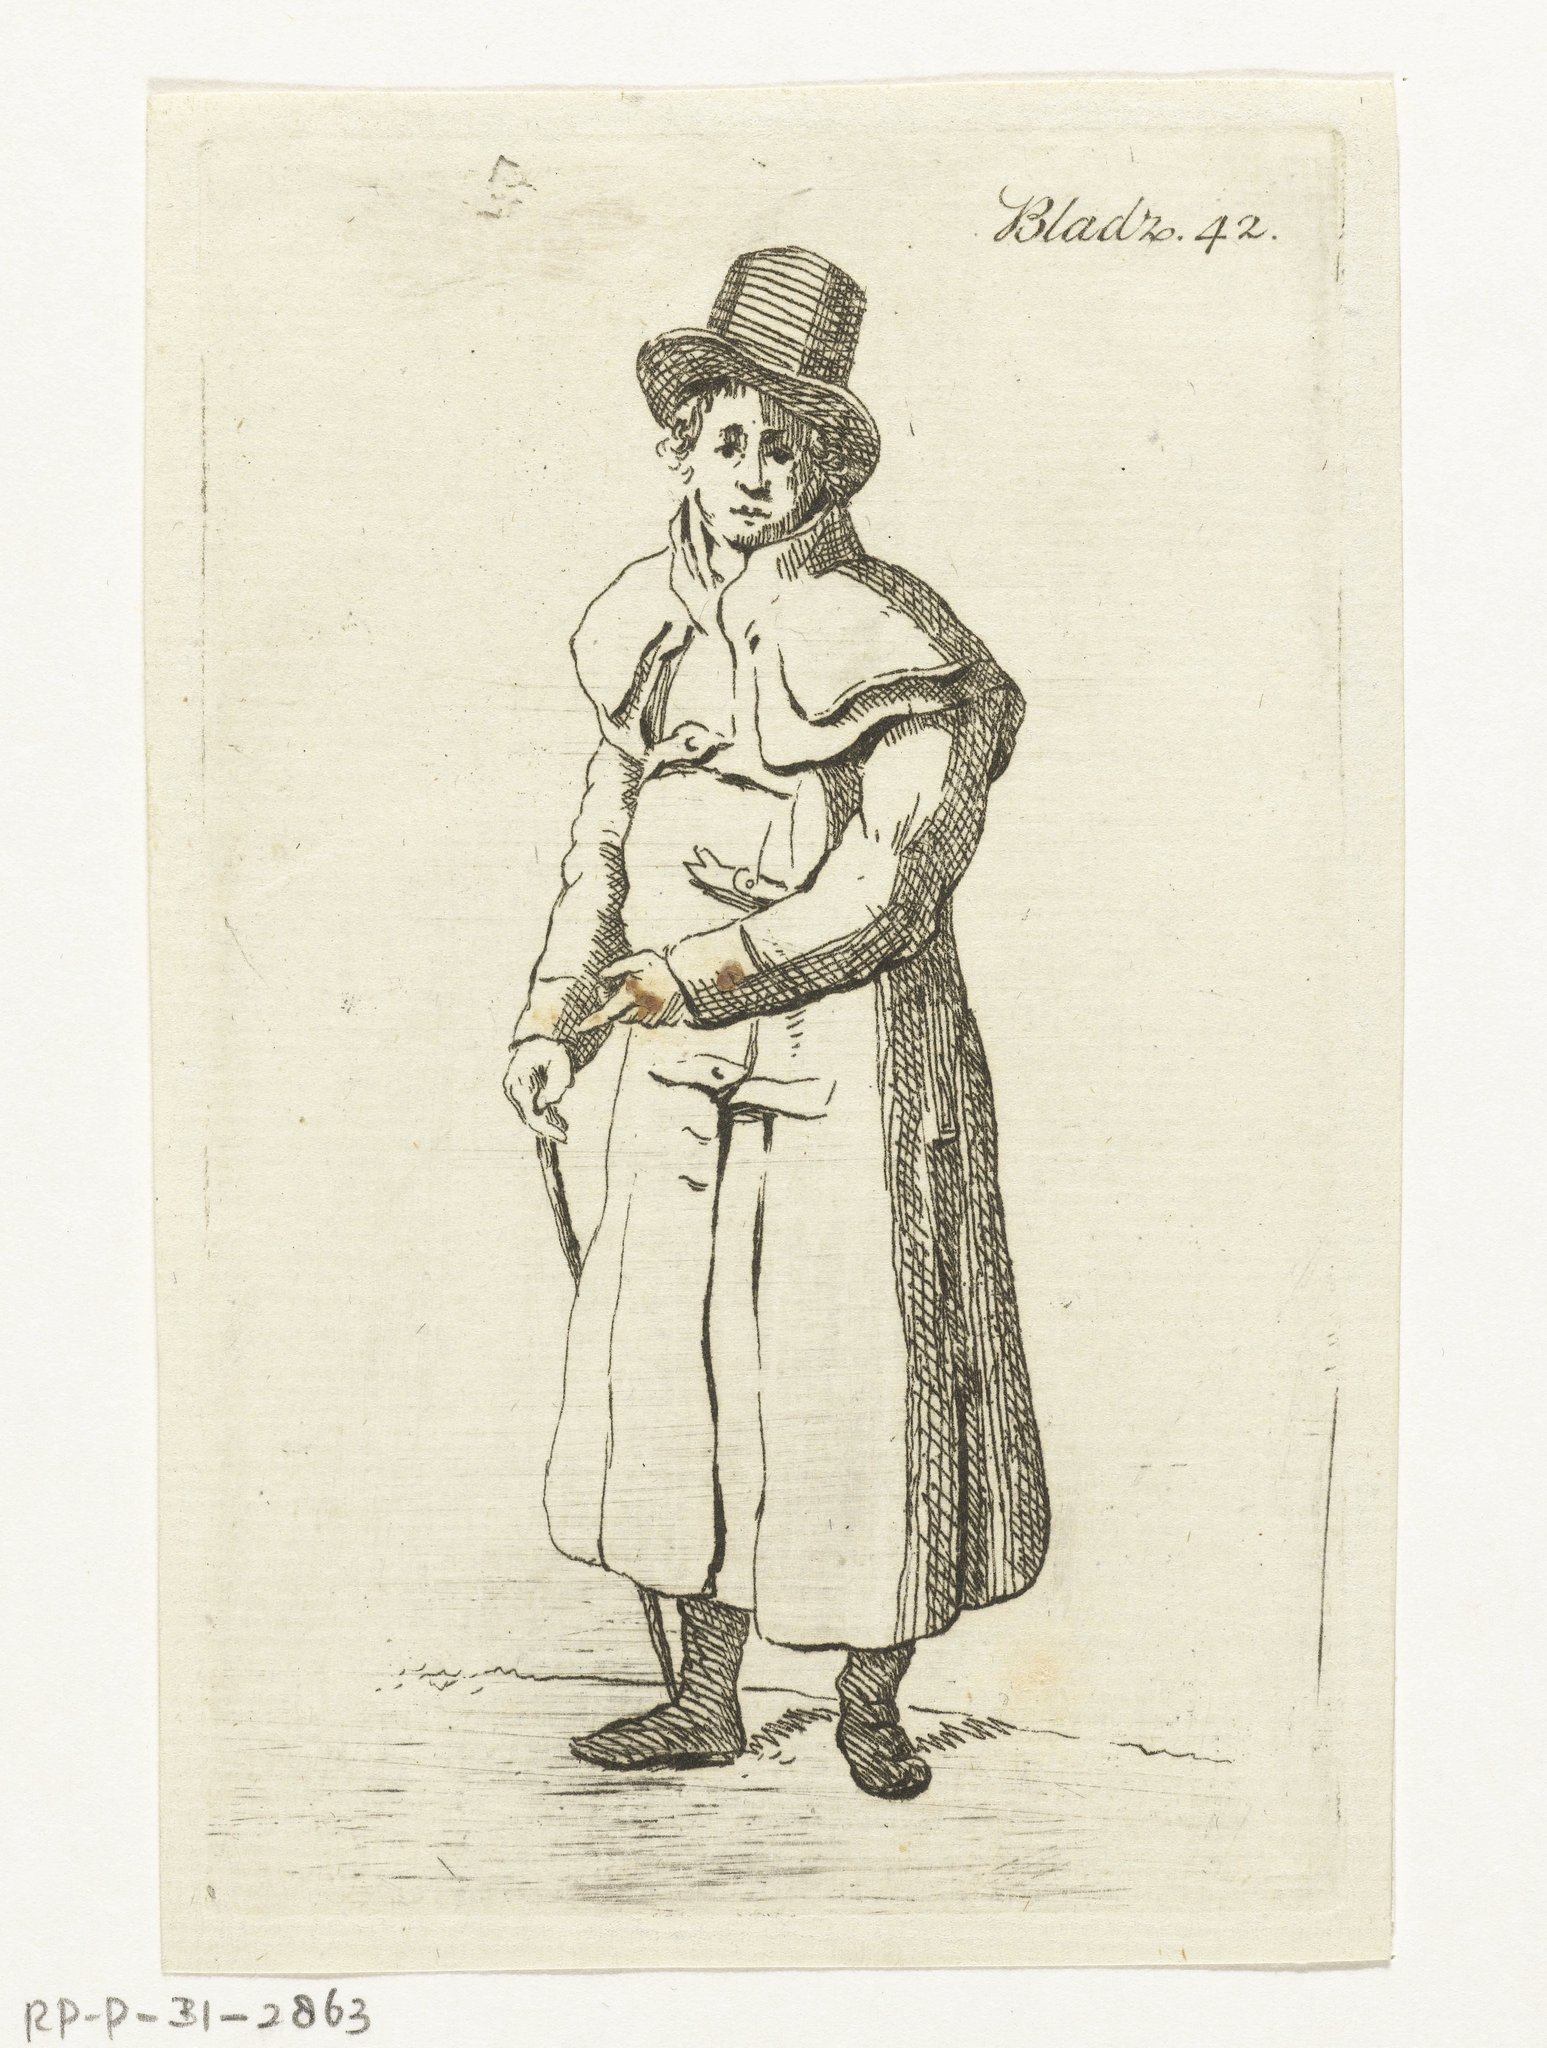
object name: print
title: Staande figuren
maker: anthonie van den bos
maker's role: draughtsman, print maker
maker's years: 1763-1838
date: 1778-1838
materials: paper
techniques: etching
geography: netherlands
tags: standing figure (canon, proportions)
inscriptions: collector's mark: Lugt 2228